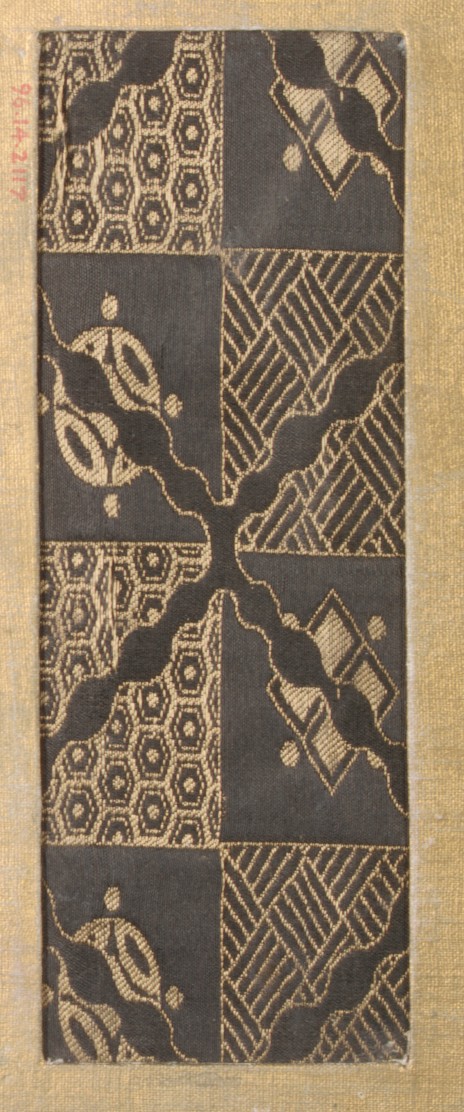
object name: piece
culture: japanese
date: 1701-1900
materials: silk